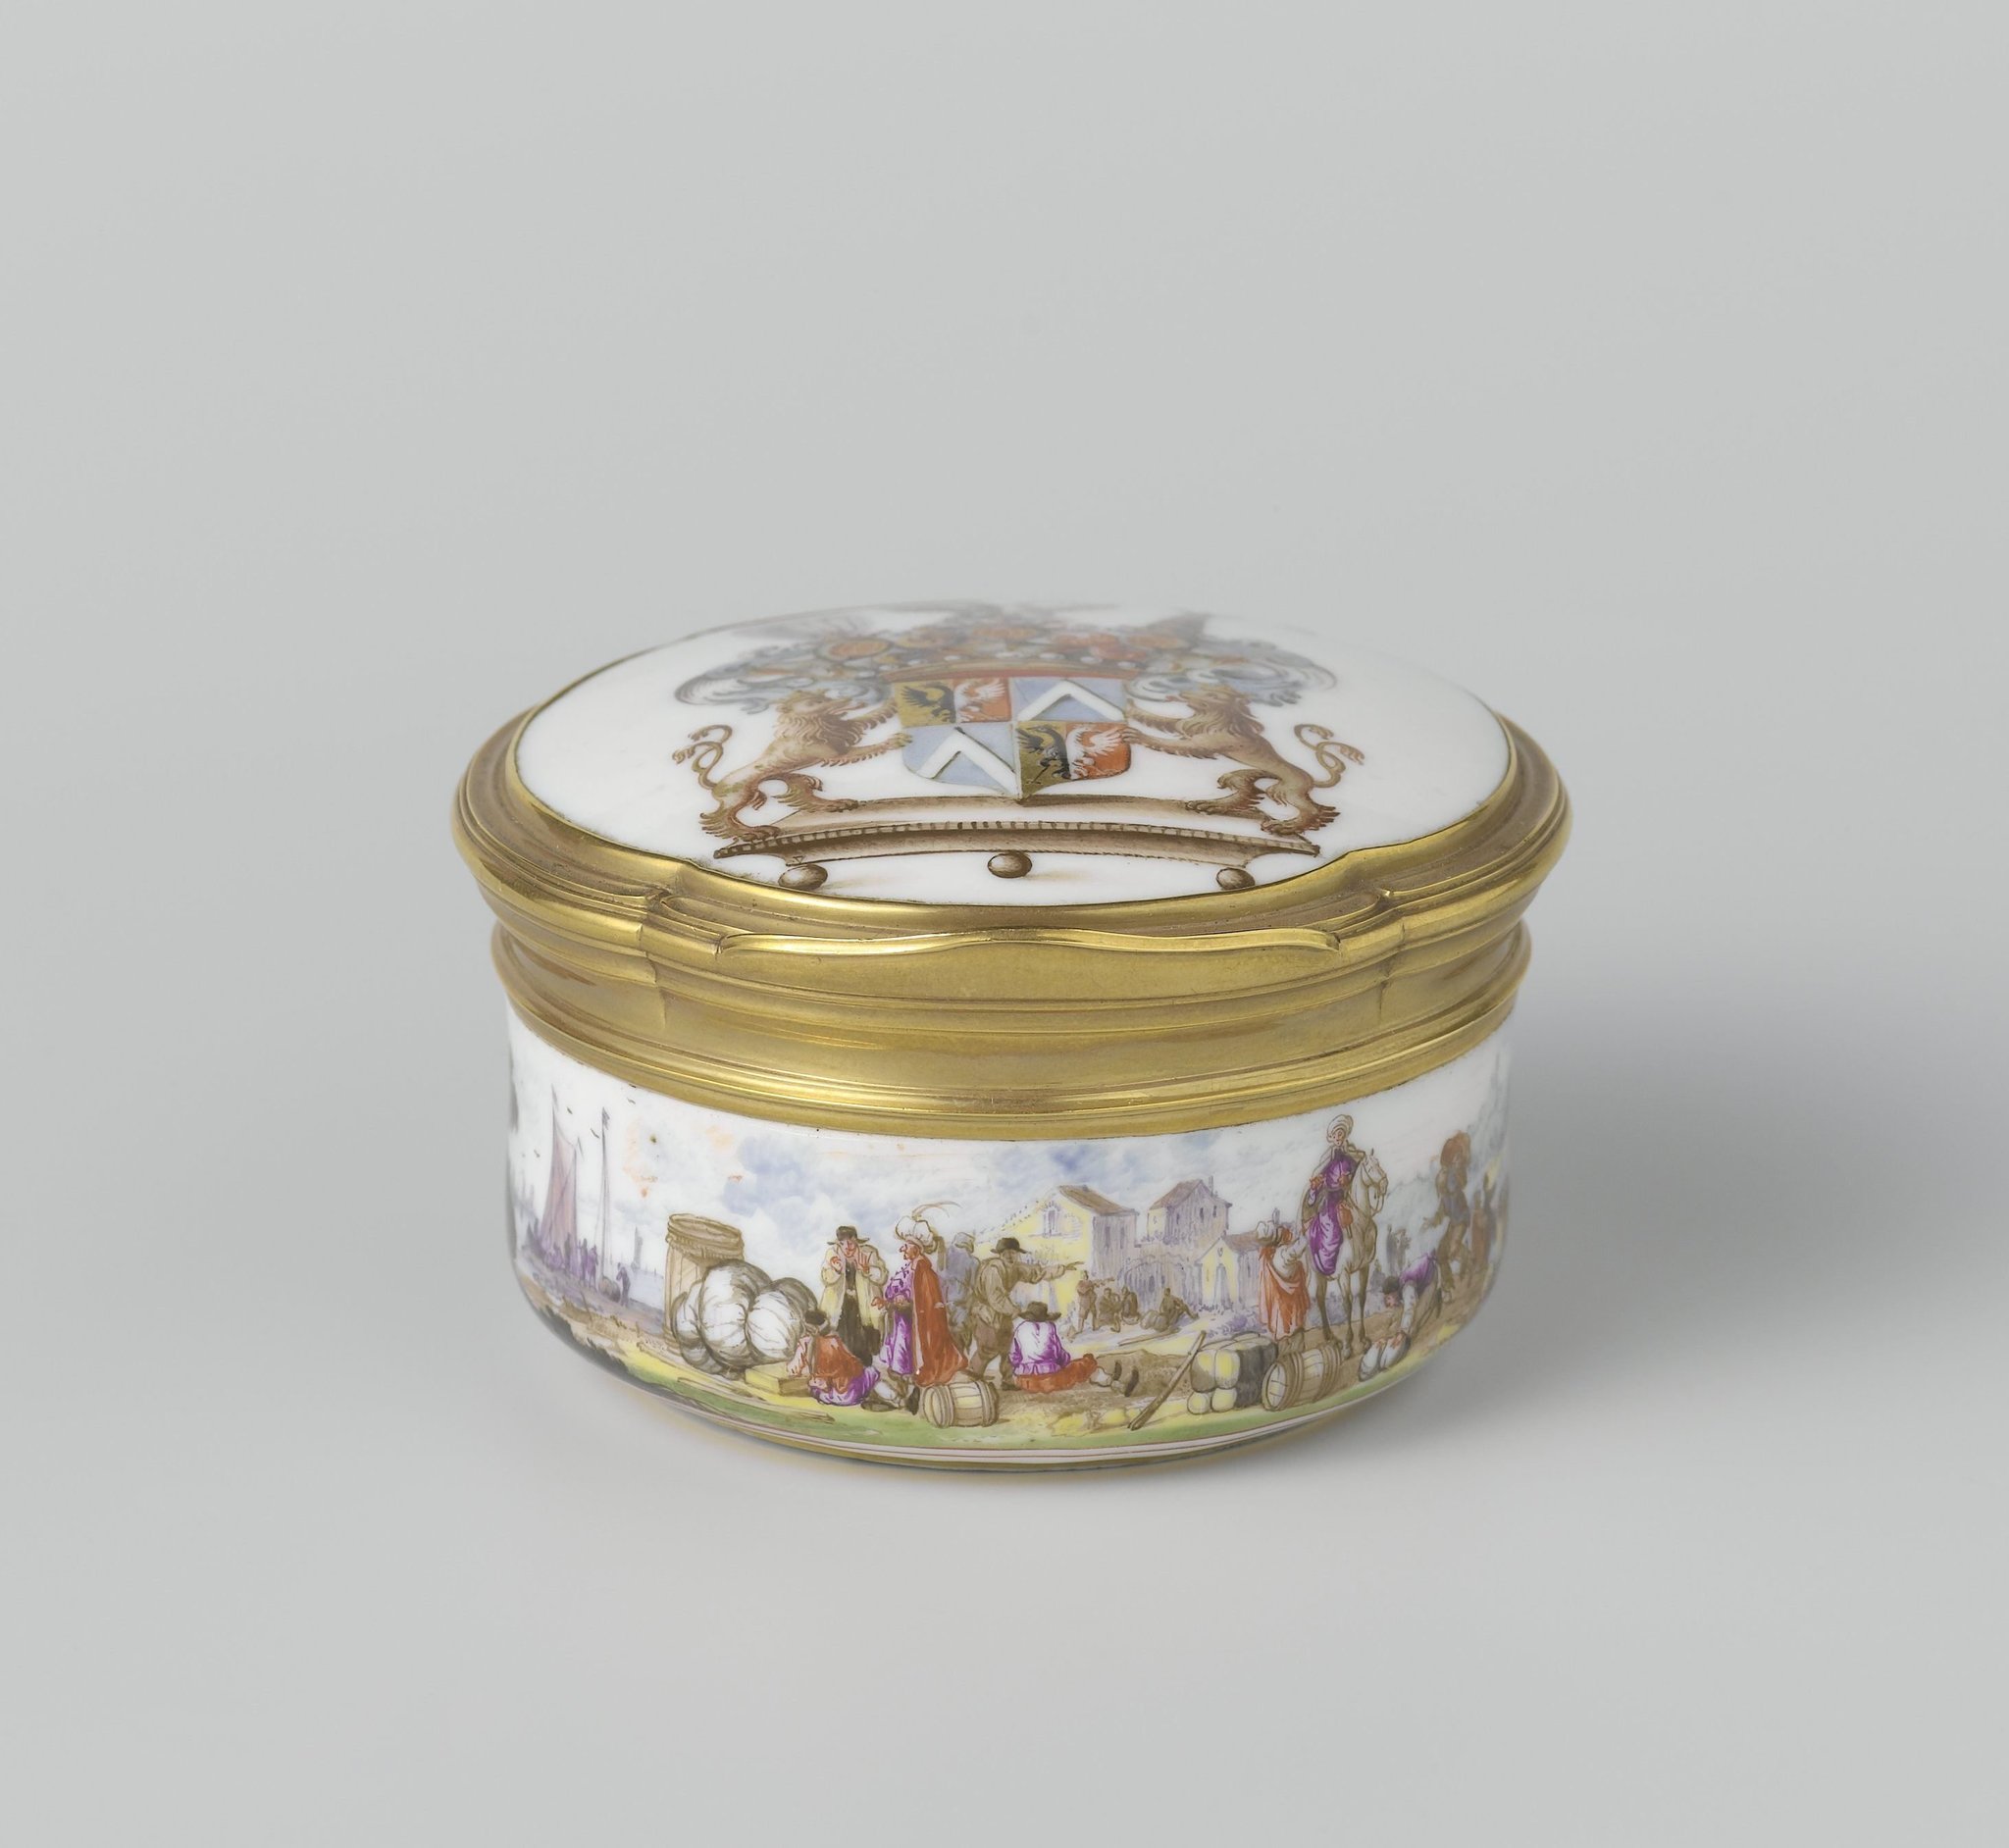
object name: snuffbox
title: Snuffbox with the Coat of Arms of Heinrich, Count von Brühl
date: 1737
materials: gold, porcelain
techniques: painted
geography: meissen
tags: heinrich von brühl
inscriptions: mark, town mark, import mark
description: Snuifdoos van beschilderd porselein. De ronde doos is door een gouden gelobd montuur met het deksel verbonden. Op het deksel is aan de buitenkant het wapen van Heinrich graaf von Brühl (1700-1763) geschilderd en aan de binnenkant een riviergezicht met figuren op de oever. De doos heeft een ingesnoerde wand en is rondom beschilderd met een rivierlandschap met op de oever figuren bij tonnen en balen. Op de bodem is een jagersscène in een bos geschilderd. De doos is niet gemerkt.